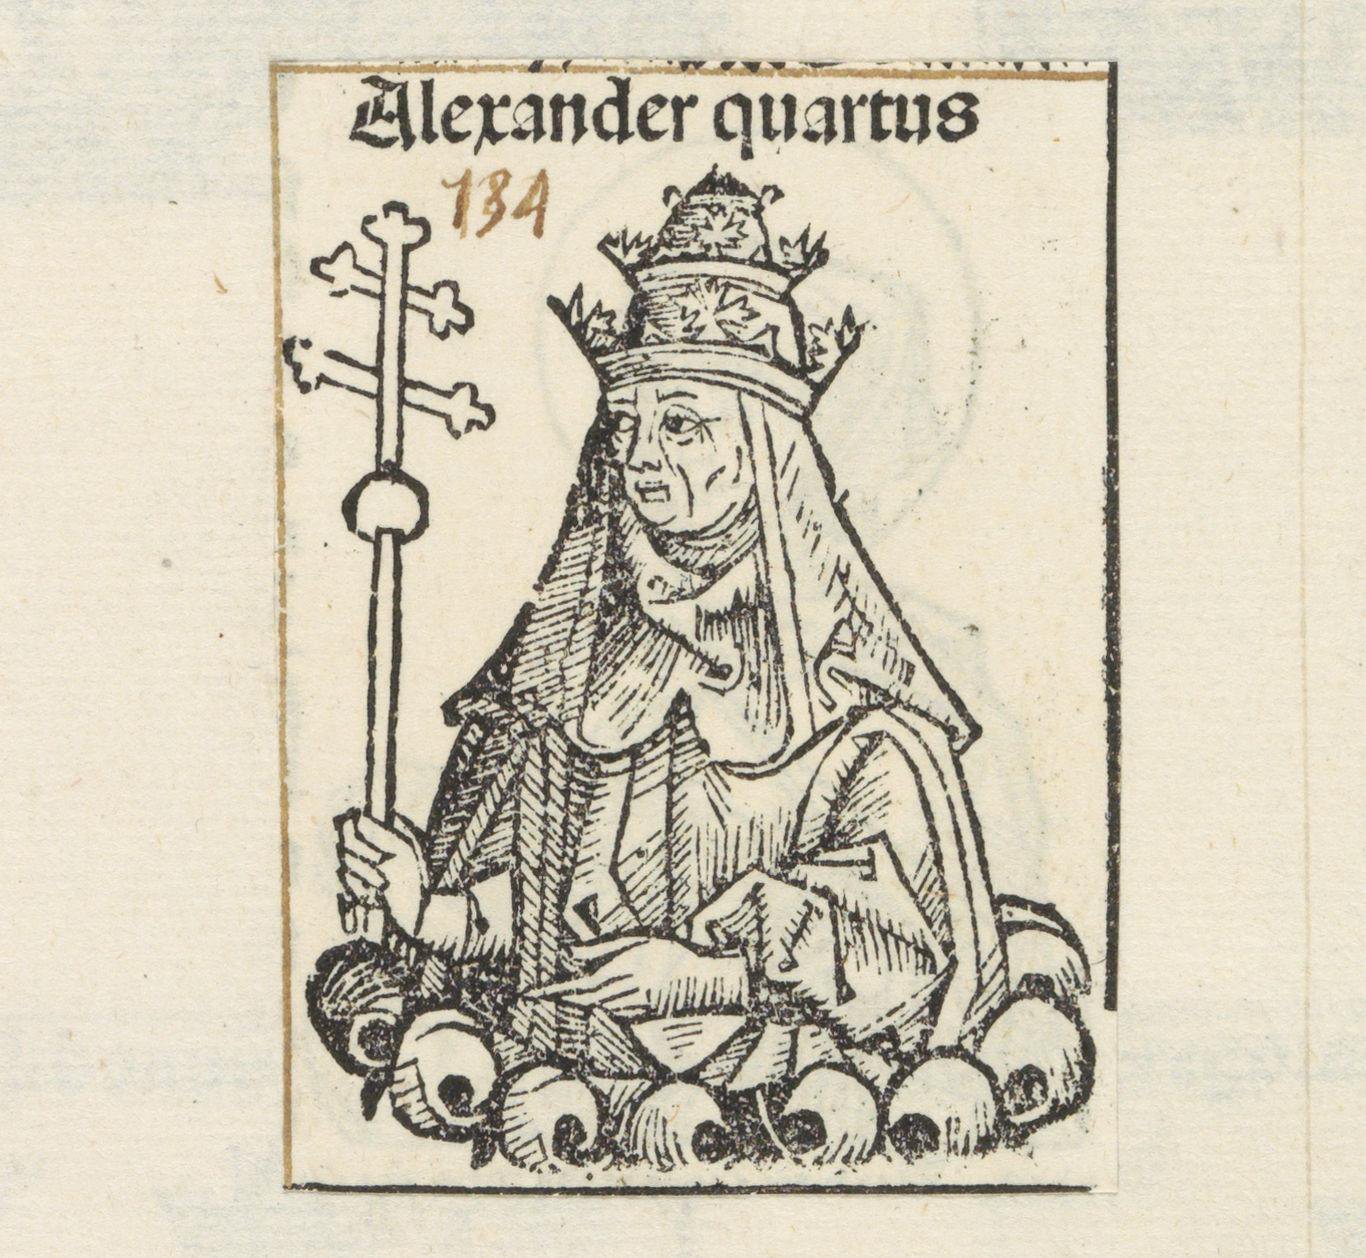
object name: album leaf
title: Paus Alexander IV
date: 1493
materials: paper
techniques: letterpress printing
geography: nuremberg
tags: pope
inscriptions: inscription: ‘134’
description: Een bloemkelk met een paus. Hij draagt een tiara en heeft een staf met dubbel kruis in zijn handen. De voorstelling is onderdeel van de opeenvolging pausen in de Liber Chronicarum. De tekst identificeert de man als Alexander IV. De prent maakt deel uit van een album.